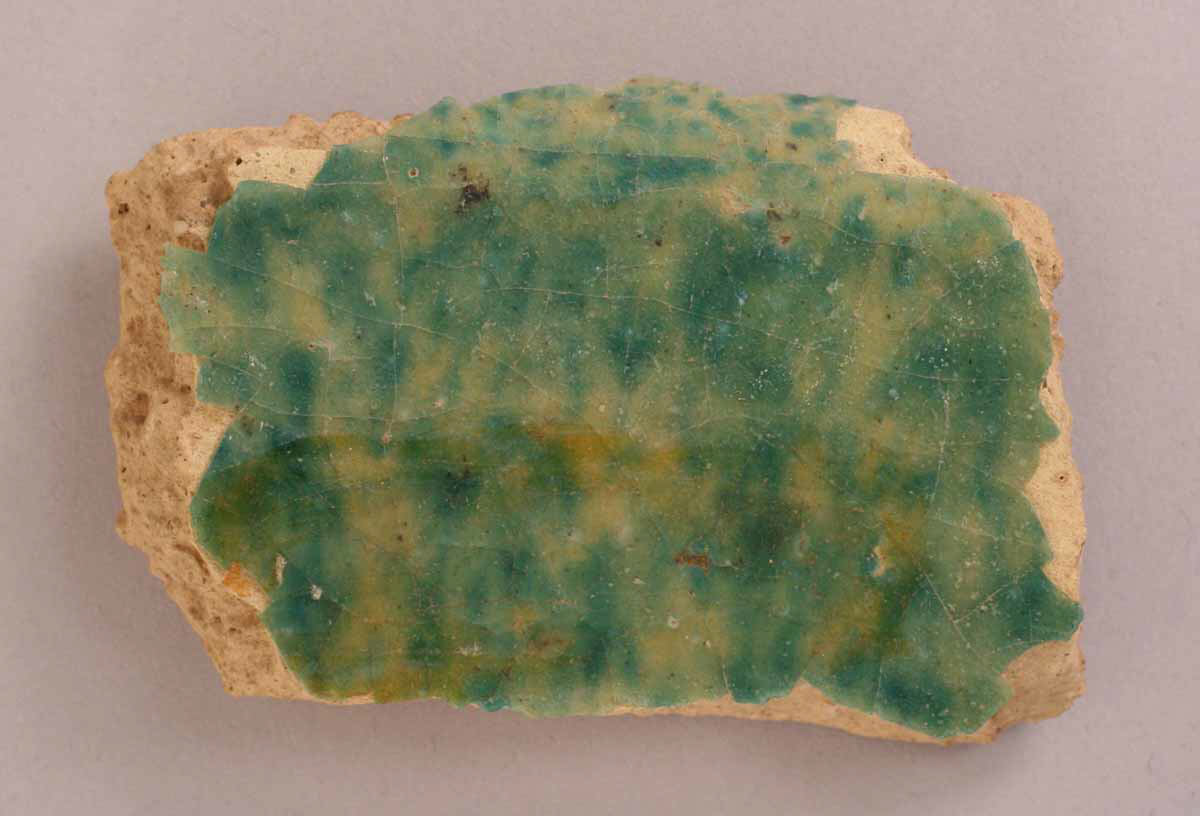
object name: fragment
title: Ceramic Fragment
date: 801-1000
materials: earthenware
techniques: glazing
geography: saudi arabia